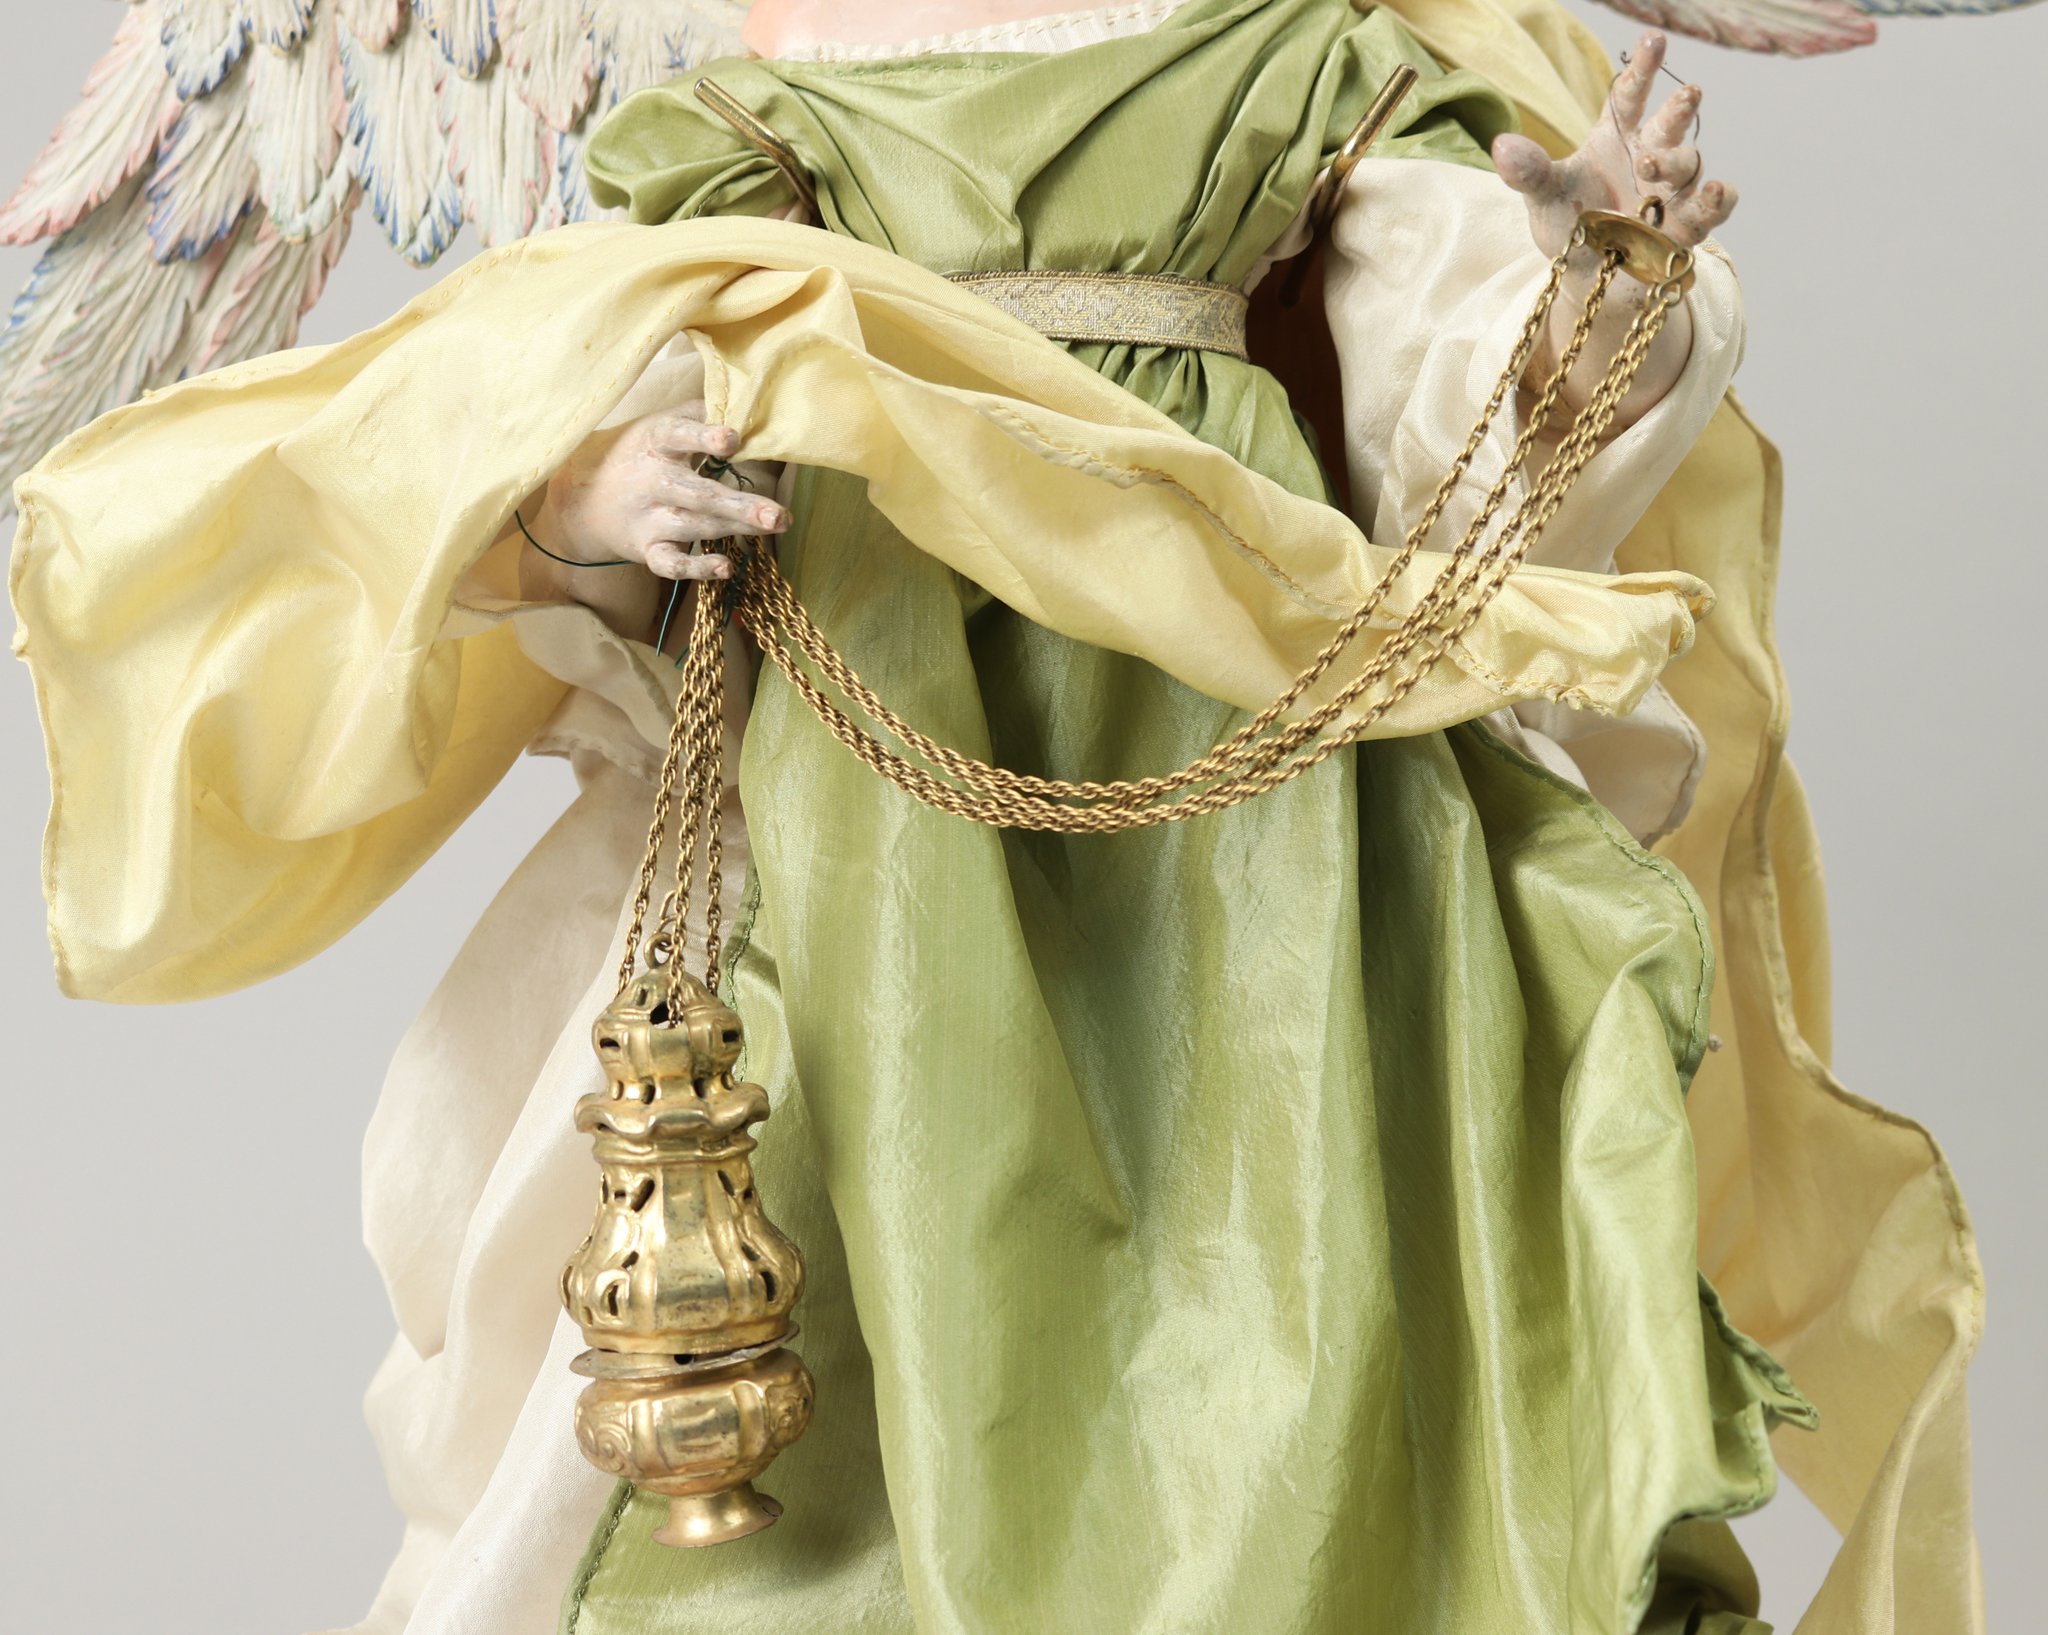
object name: crèche figure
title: Censer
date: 1701-1800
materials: silver gilt